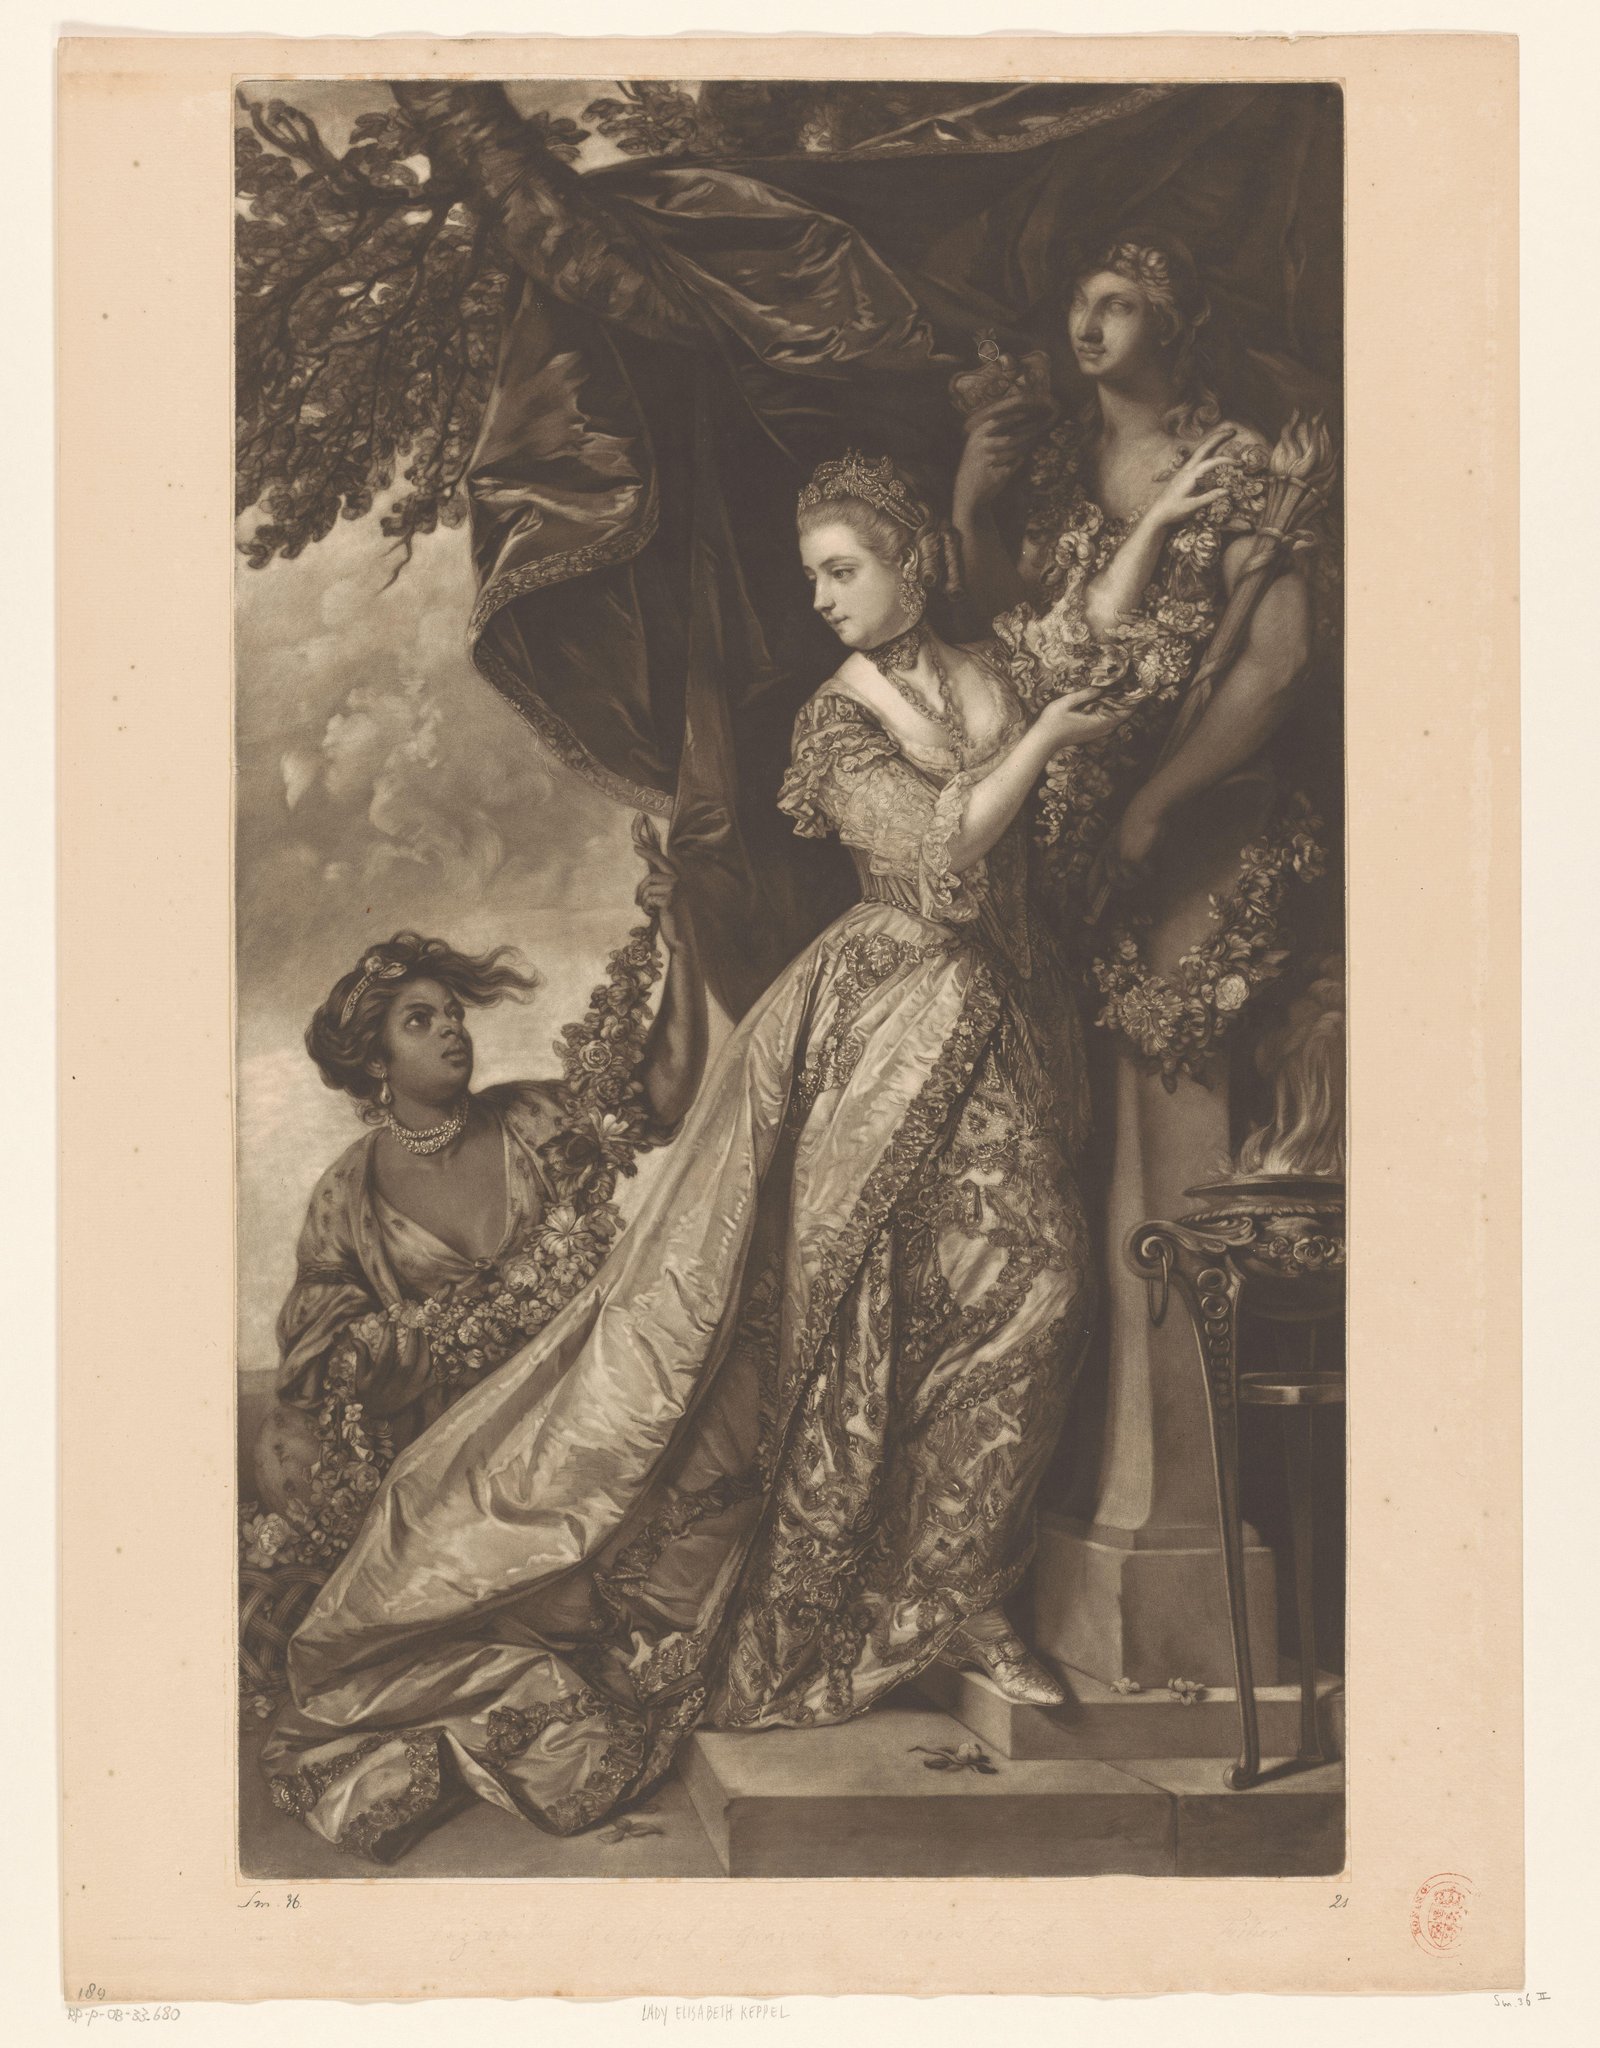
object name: print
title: Portret van Elisabeth Keppel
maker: edward fisher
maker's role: print maker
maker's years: 1722-1785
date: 1761-1785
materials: paper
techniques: mezzotint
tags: historical persons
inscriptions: collector's mark: Lugt 240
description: Tekst in het Engels in de prent. Guirlandes vastgehouden door de zwarte page, terwijl de witte vrouw bloemenkransen om een beeld op een altaar hangt.